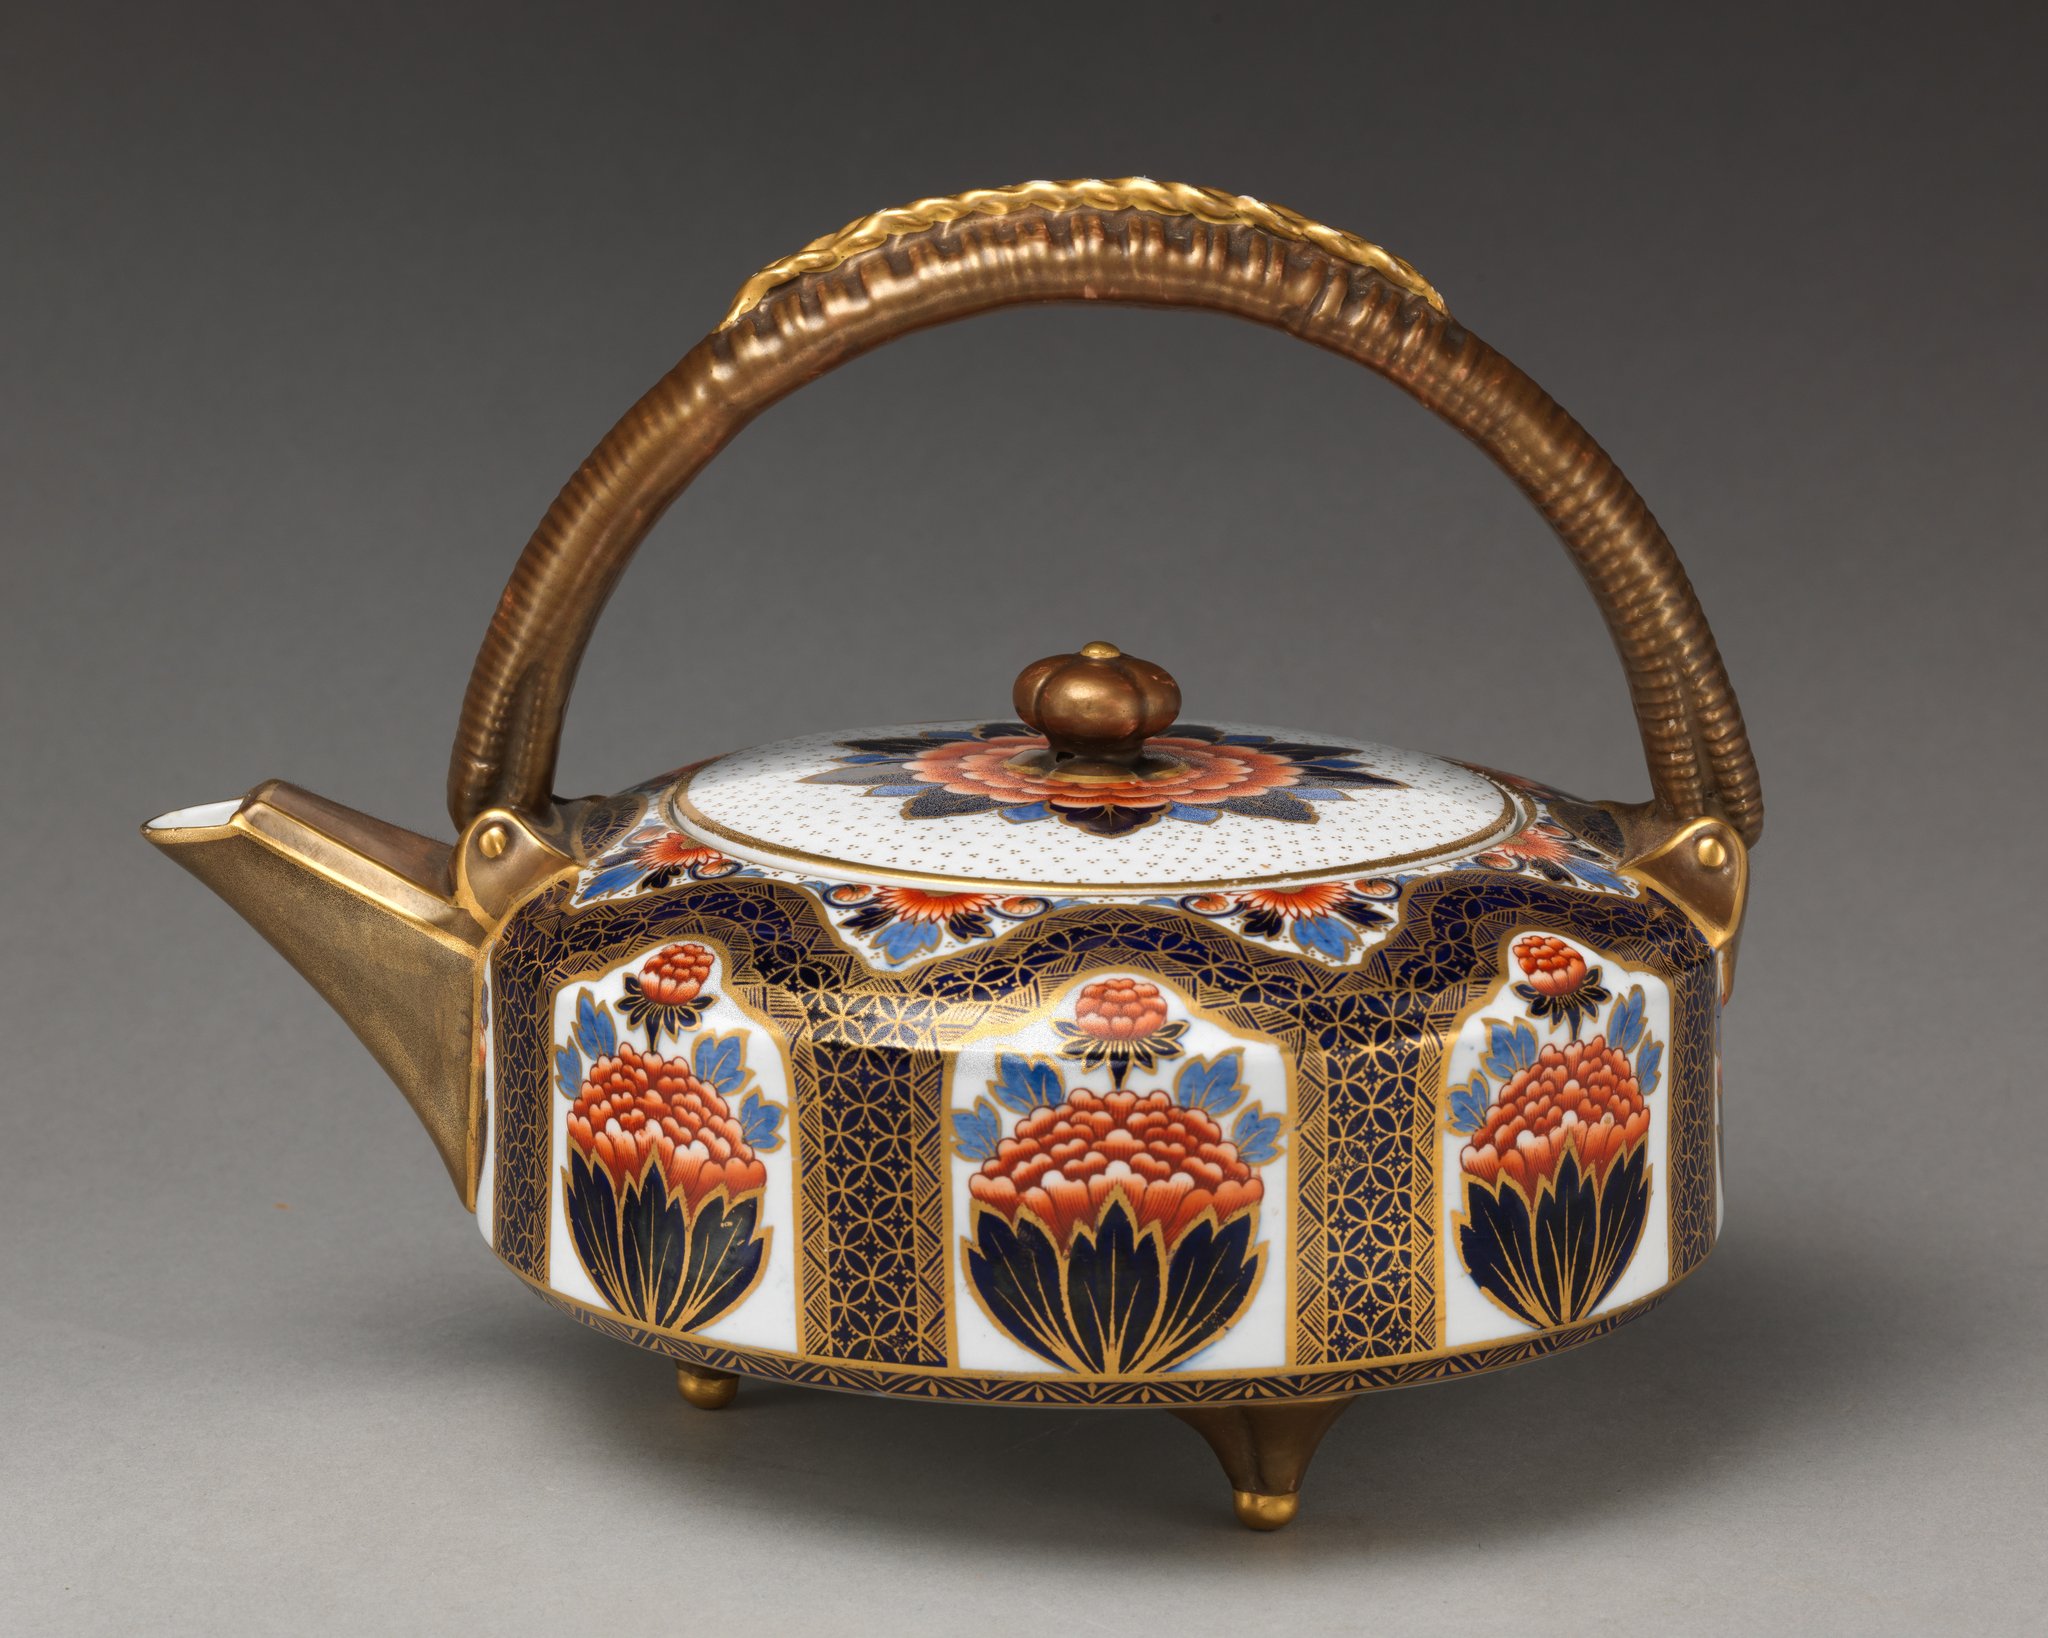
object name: teapot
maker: worcester factory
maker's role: maker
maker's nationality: british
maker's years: 1751-2008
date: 1879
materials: bone china